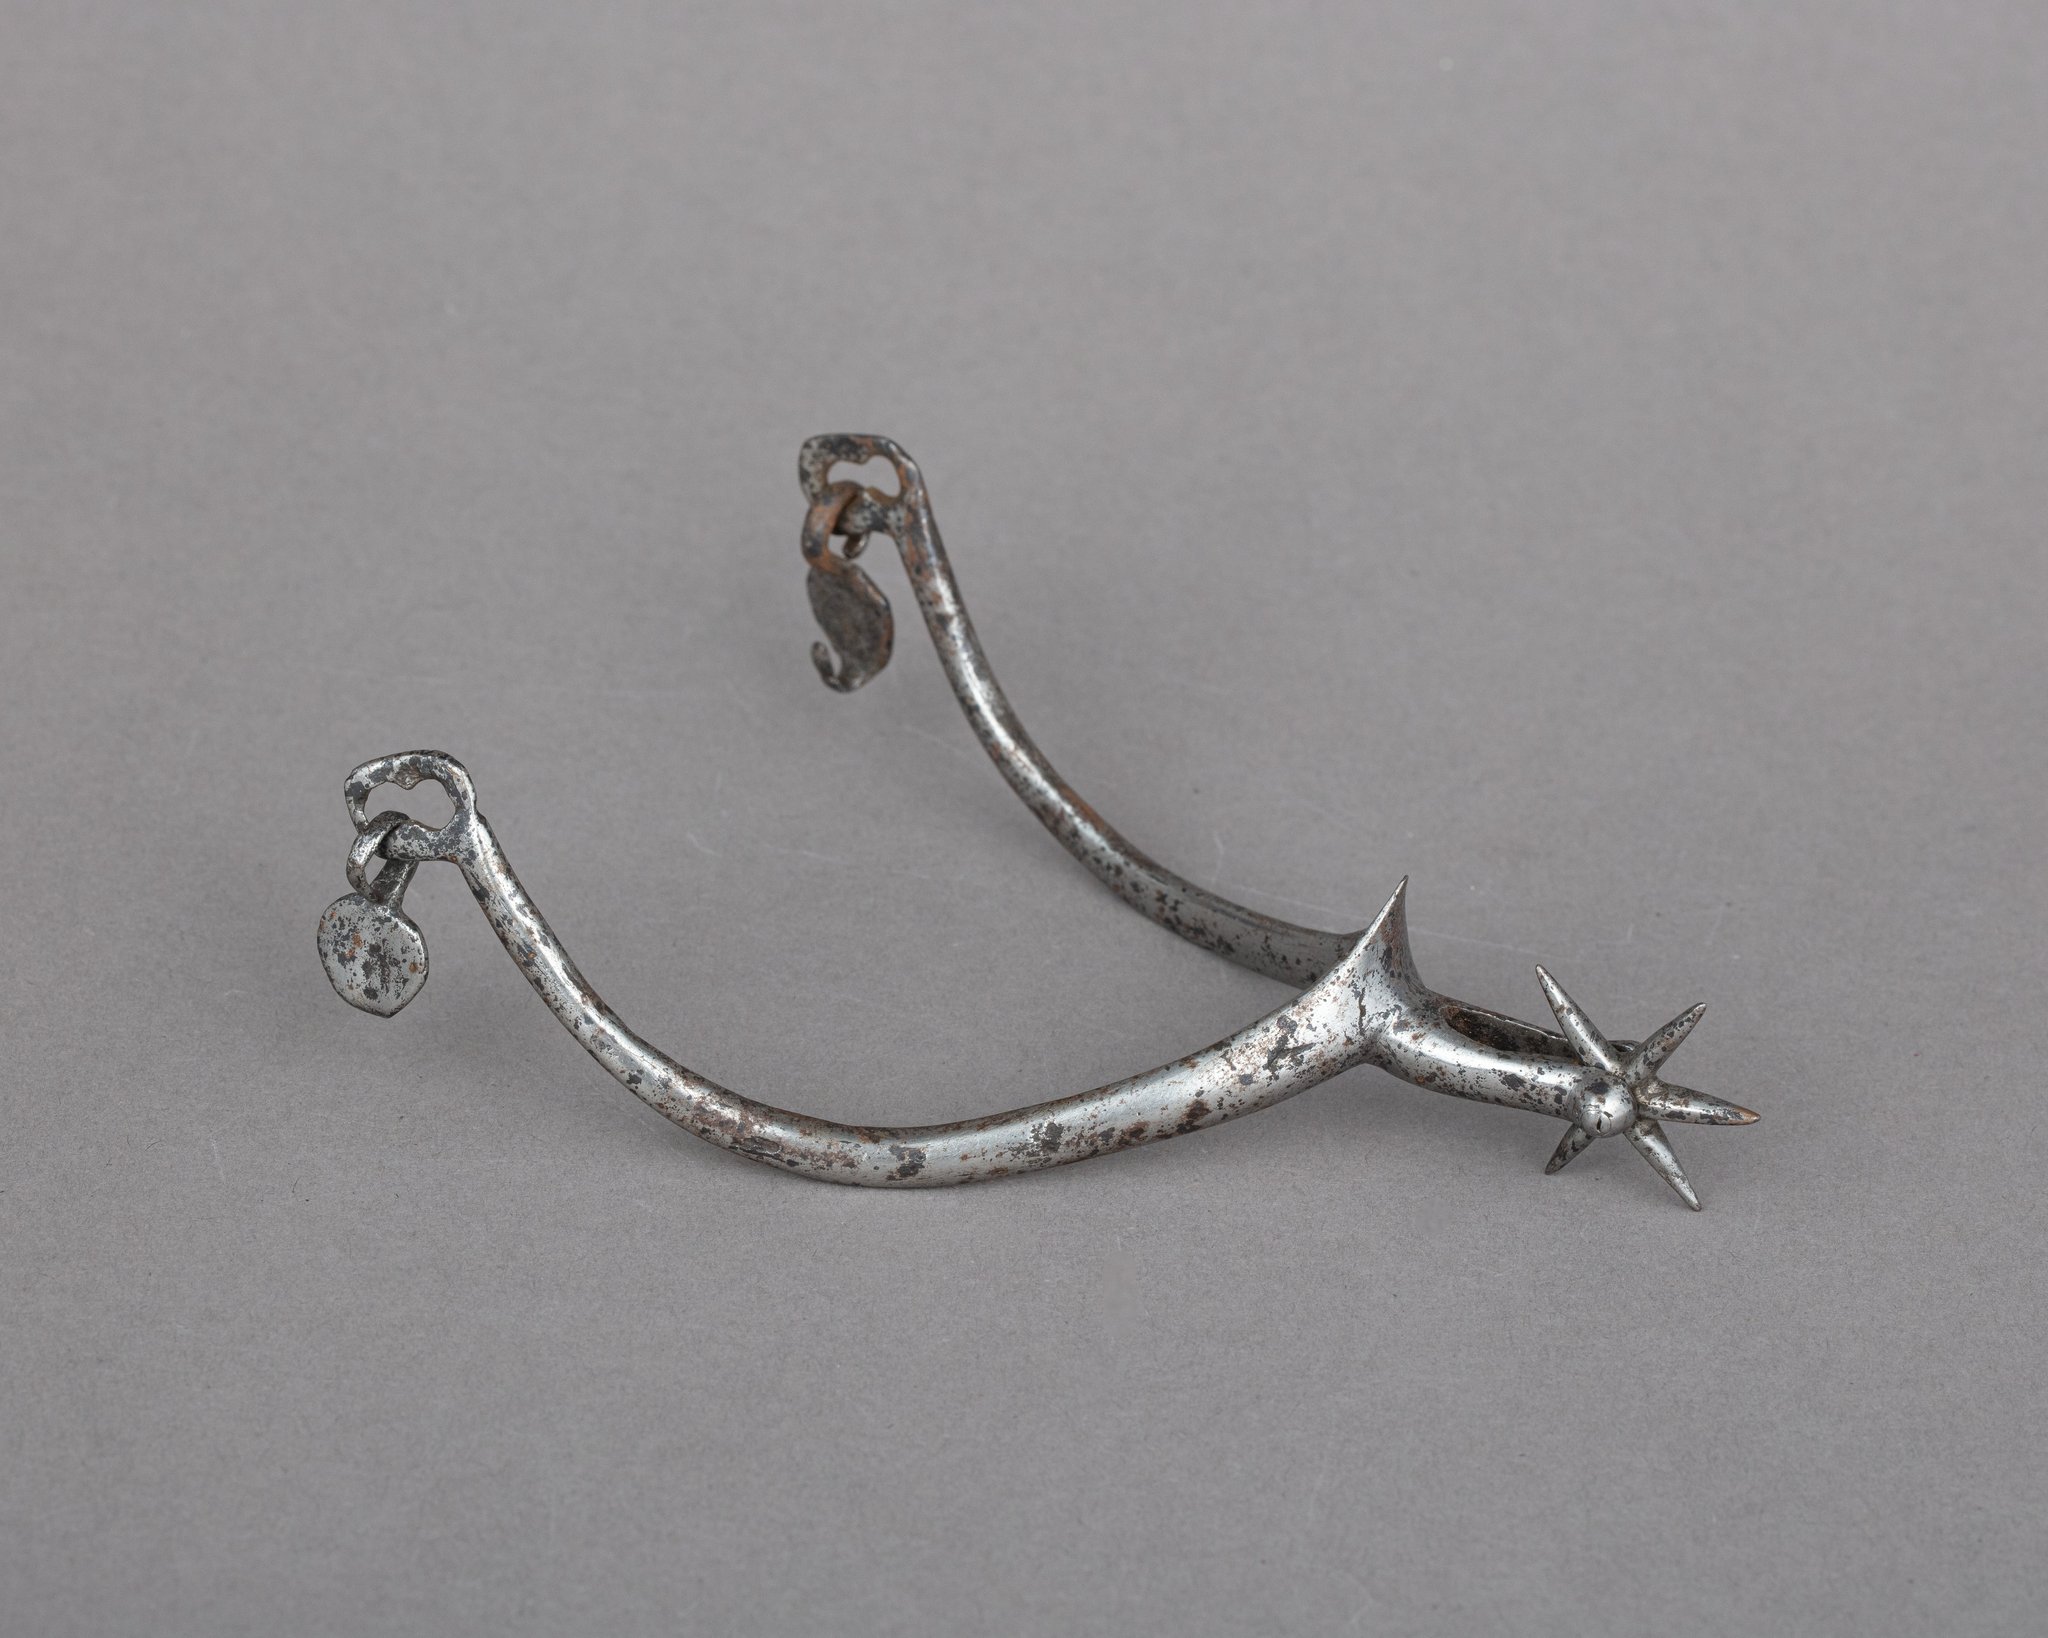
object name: spur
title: Rowel Spur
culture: italian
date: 1367-1400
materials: metal alloy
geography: italy